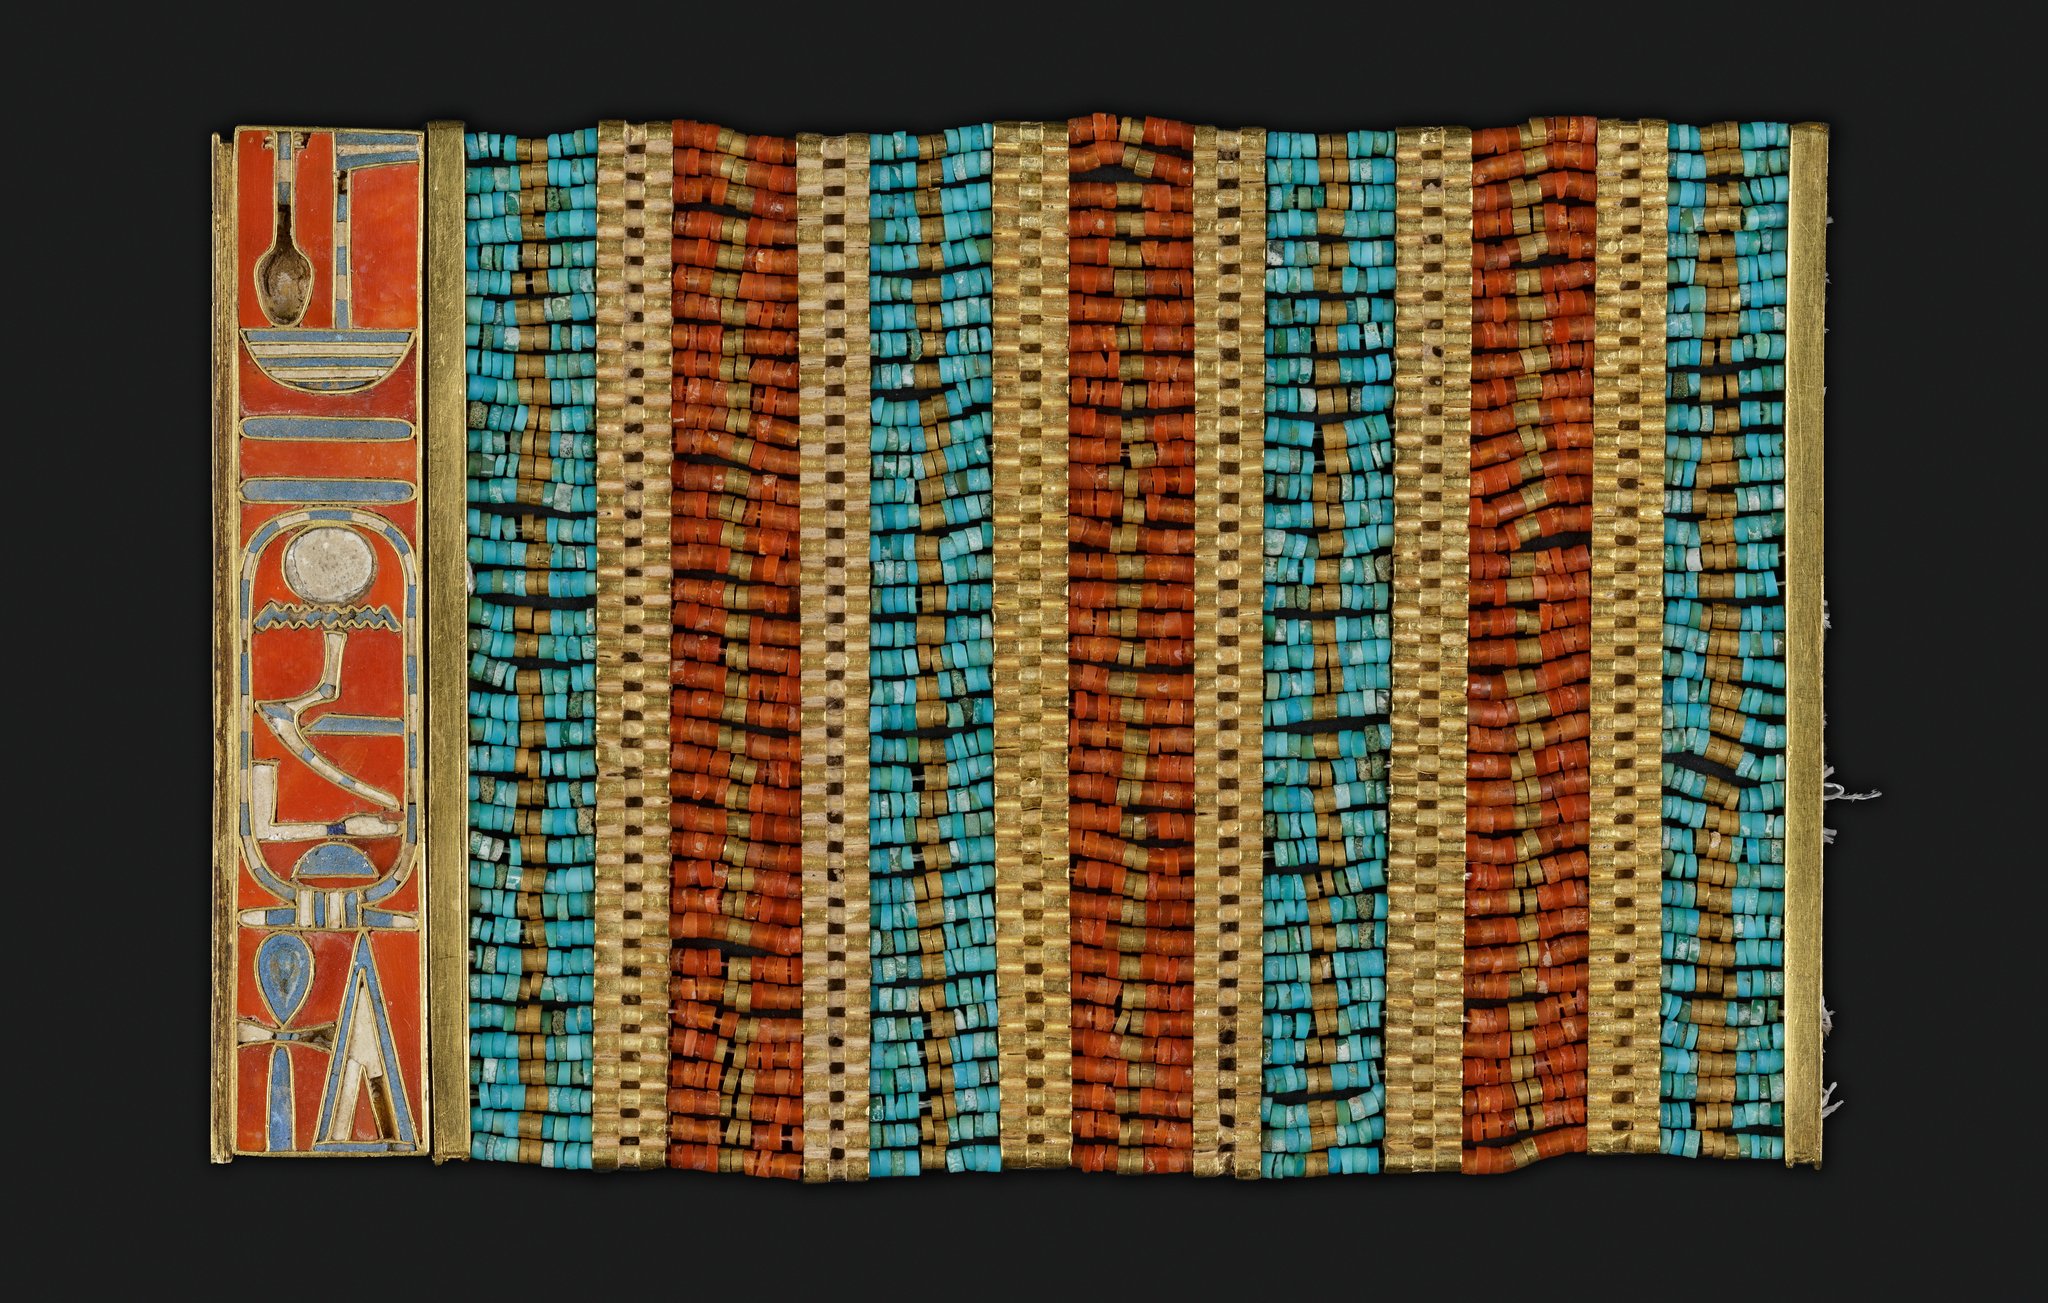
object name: bracelet, sithathoryunet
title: Broad Bracelet of Sithathoryunet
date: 1887-1813 BCE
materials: gemstone, faience, gold, lapis lazuli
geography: egypt